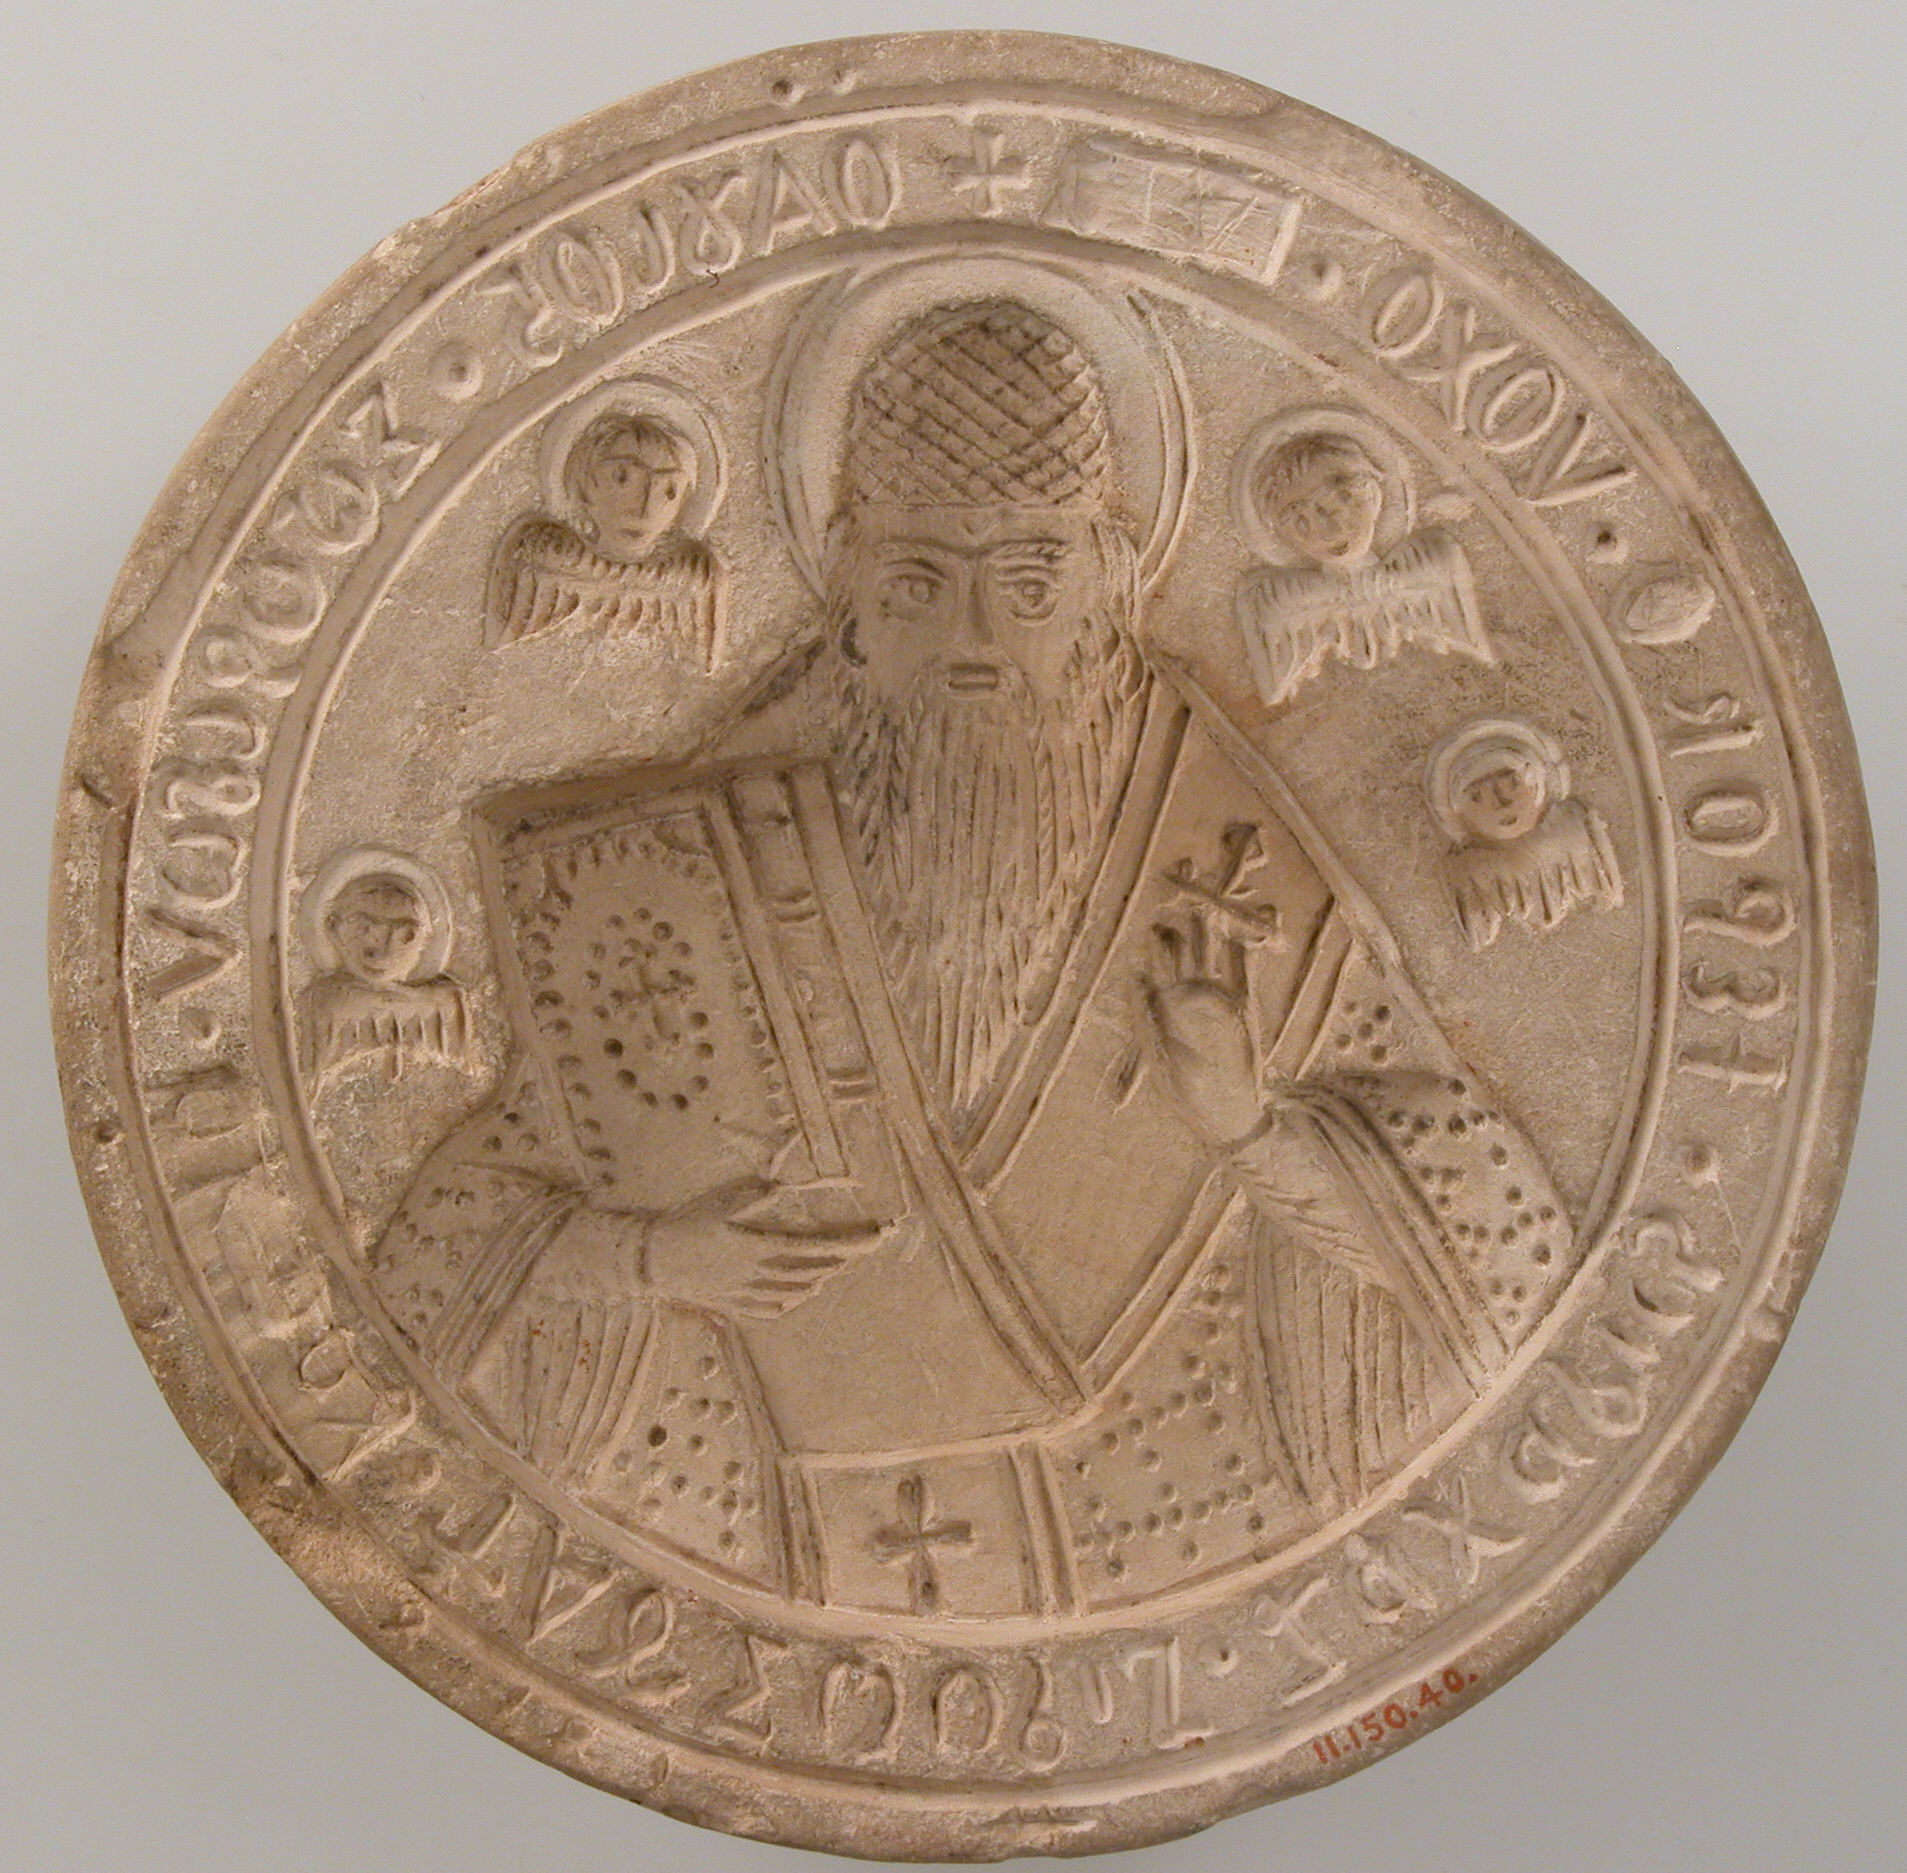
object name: stamp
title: Mould for a Stamp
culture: greek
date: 1601-1800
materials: limestone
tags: angels,saints